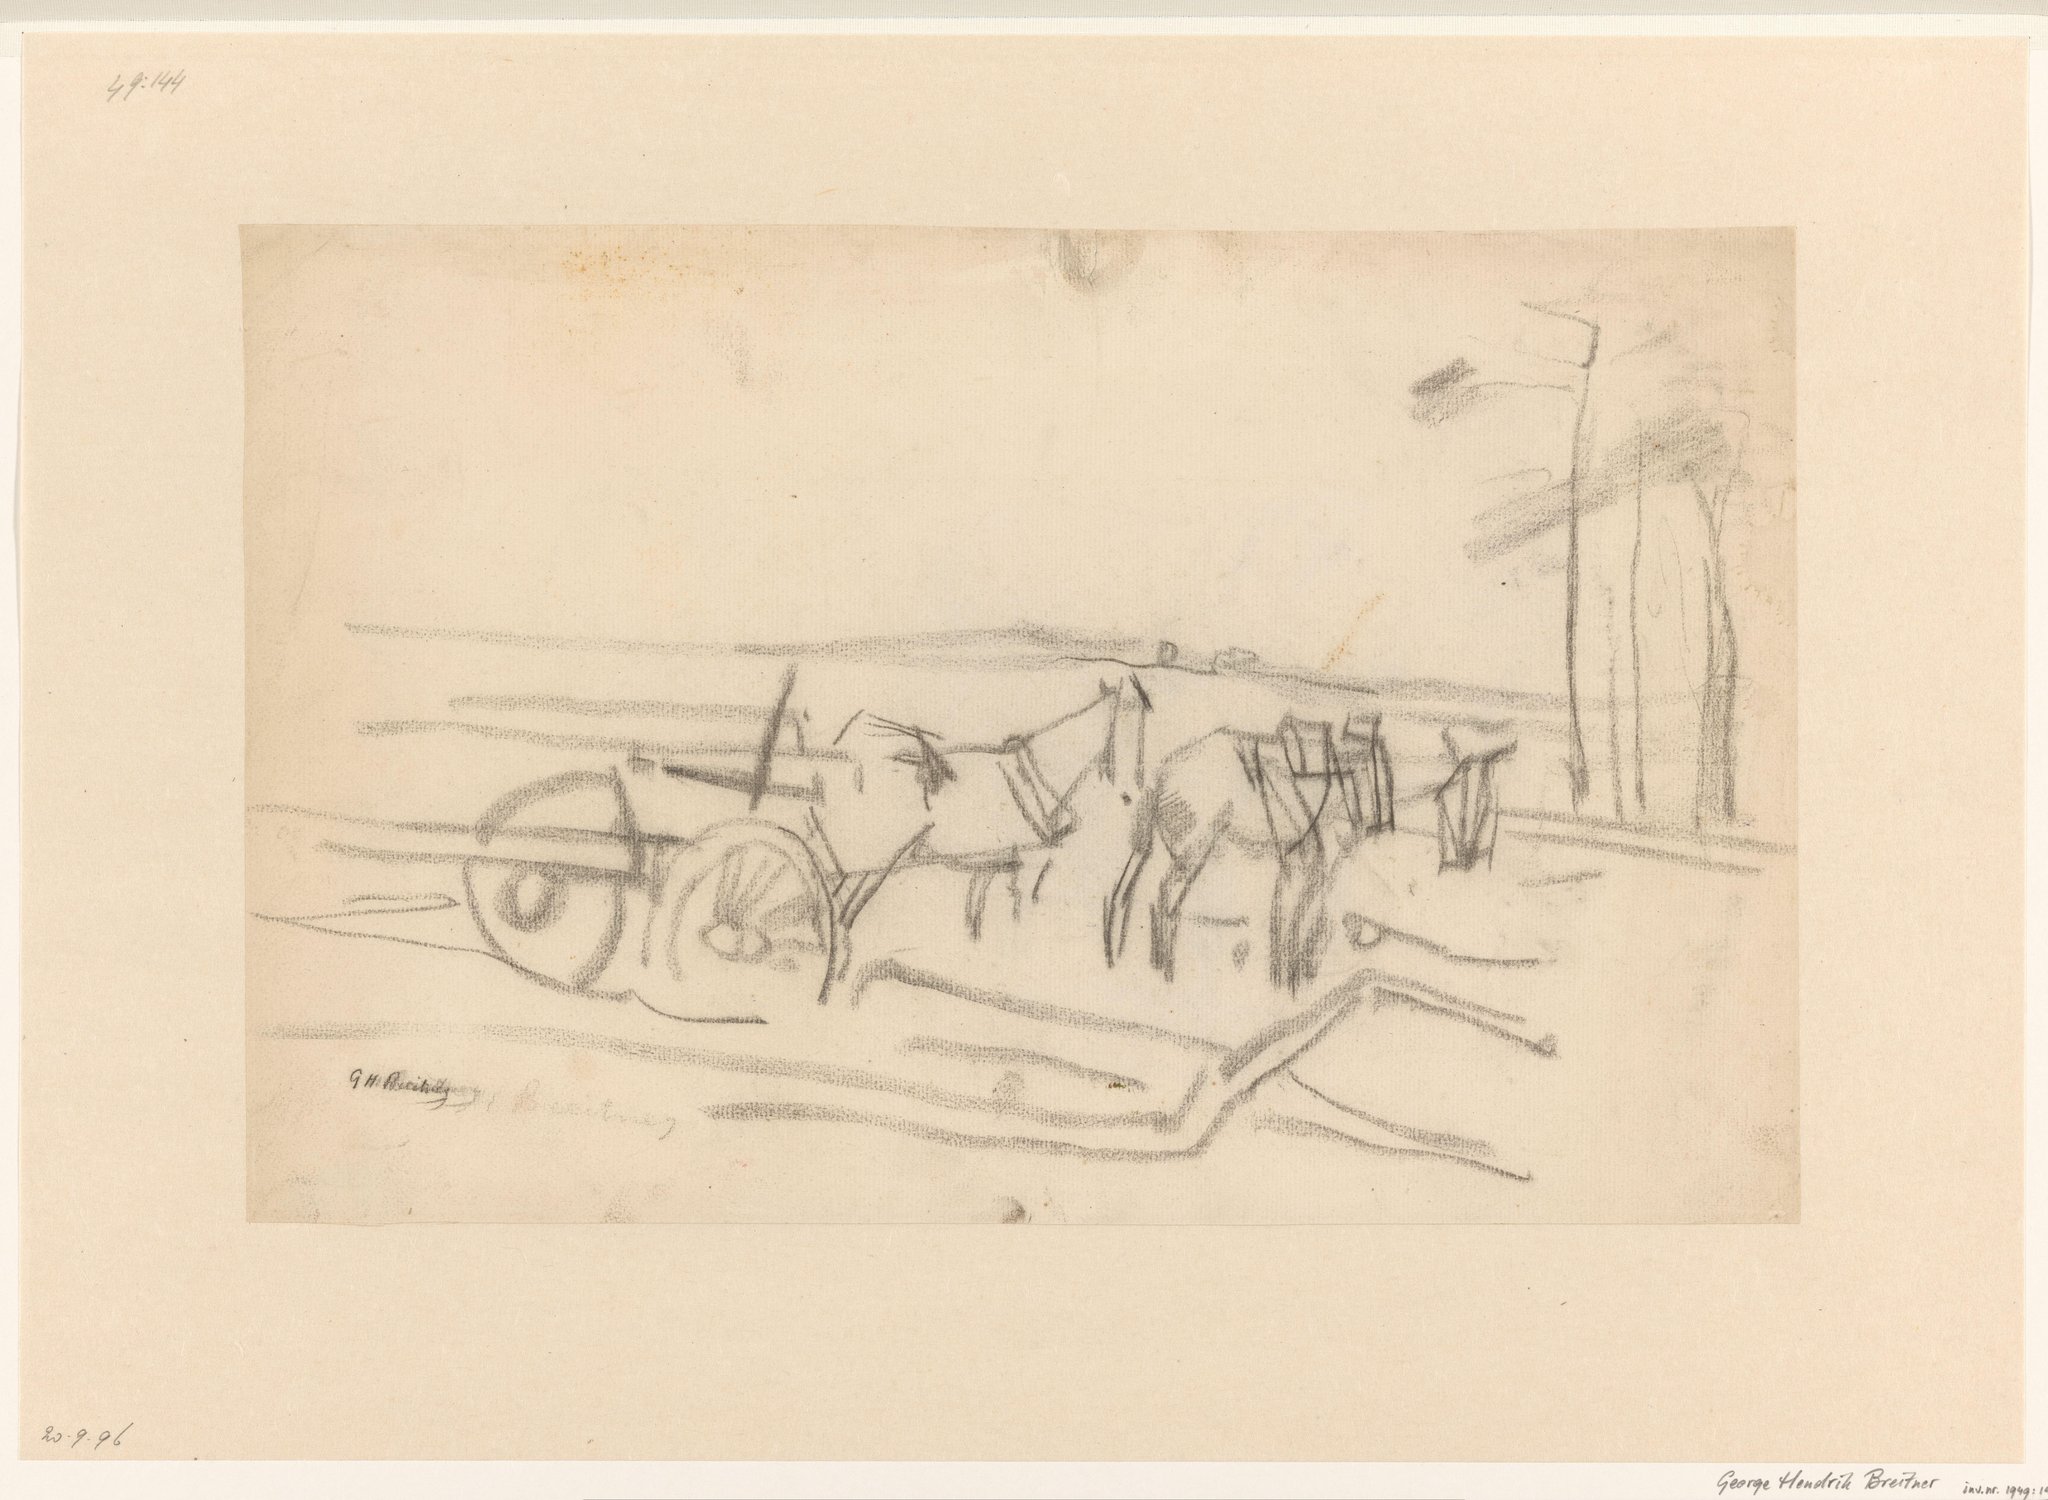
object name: drawing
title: Bespannen kanon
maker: george hendrik breitner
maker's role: draughtsman, painter, print maker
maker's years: 1857-1923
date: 1867-1923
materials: charcoal, paper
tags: firearms: cannon